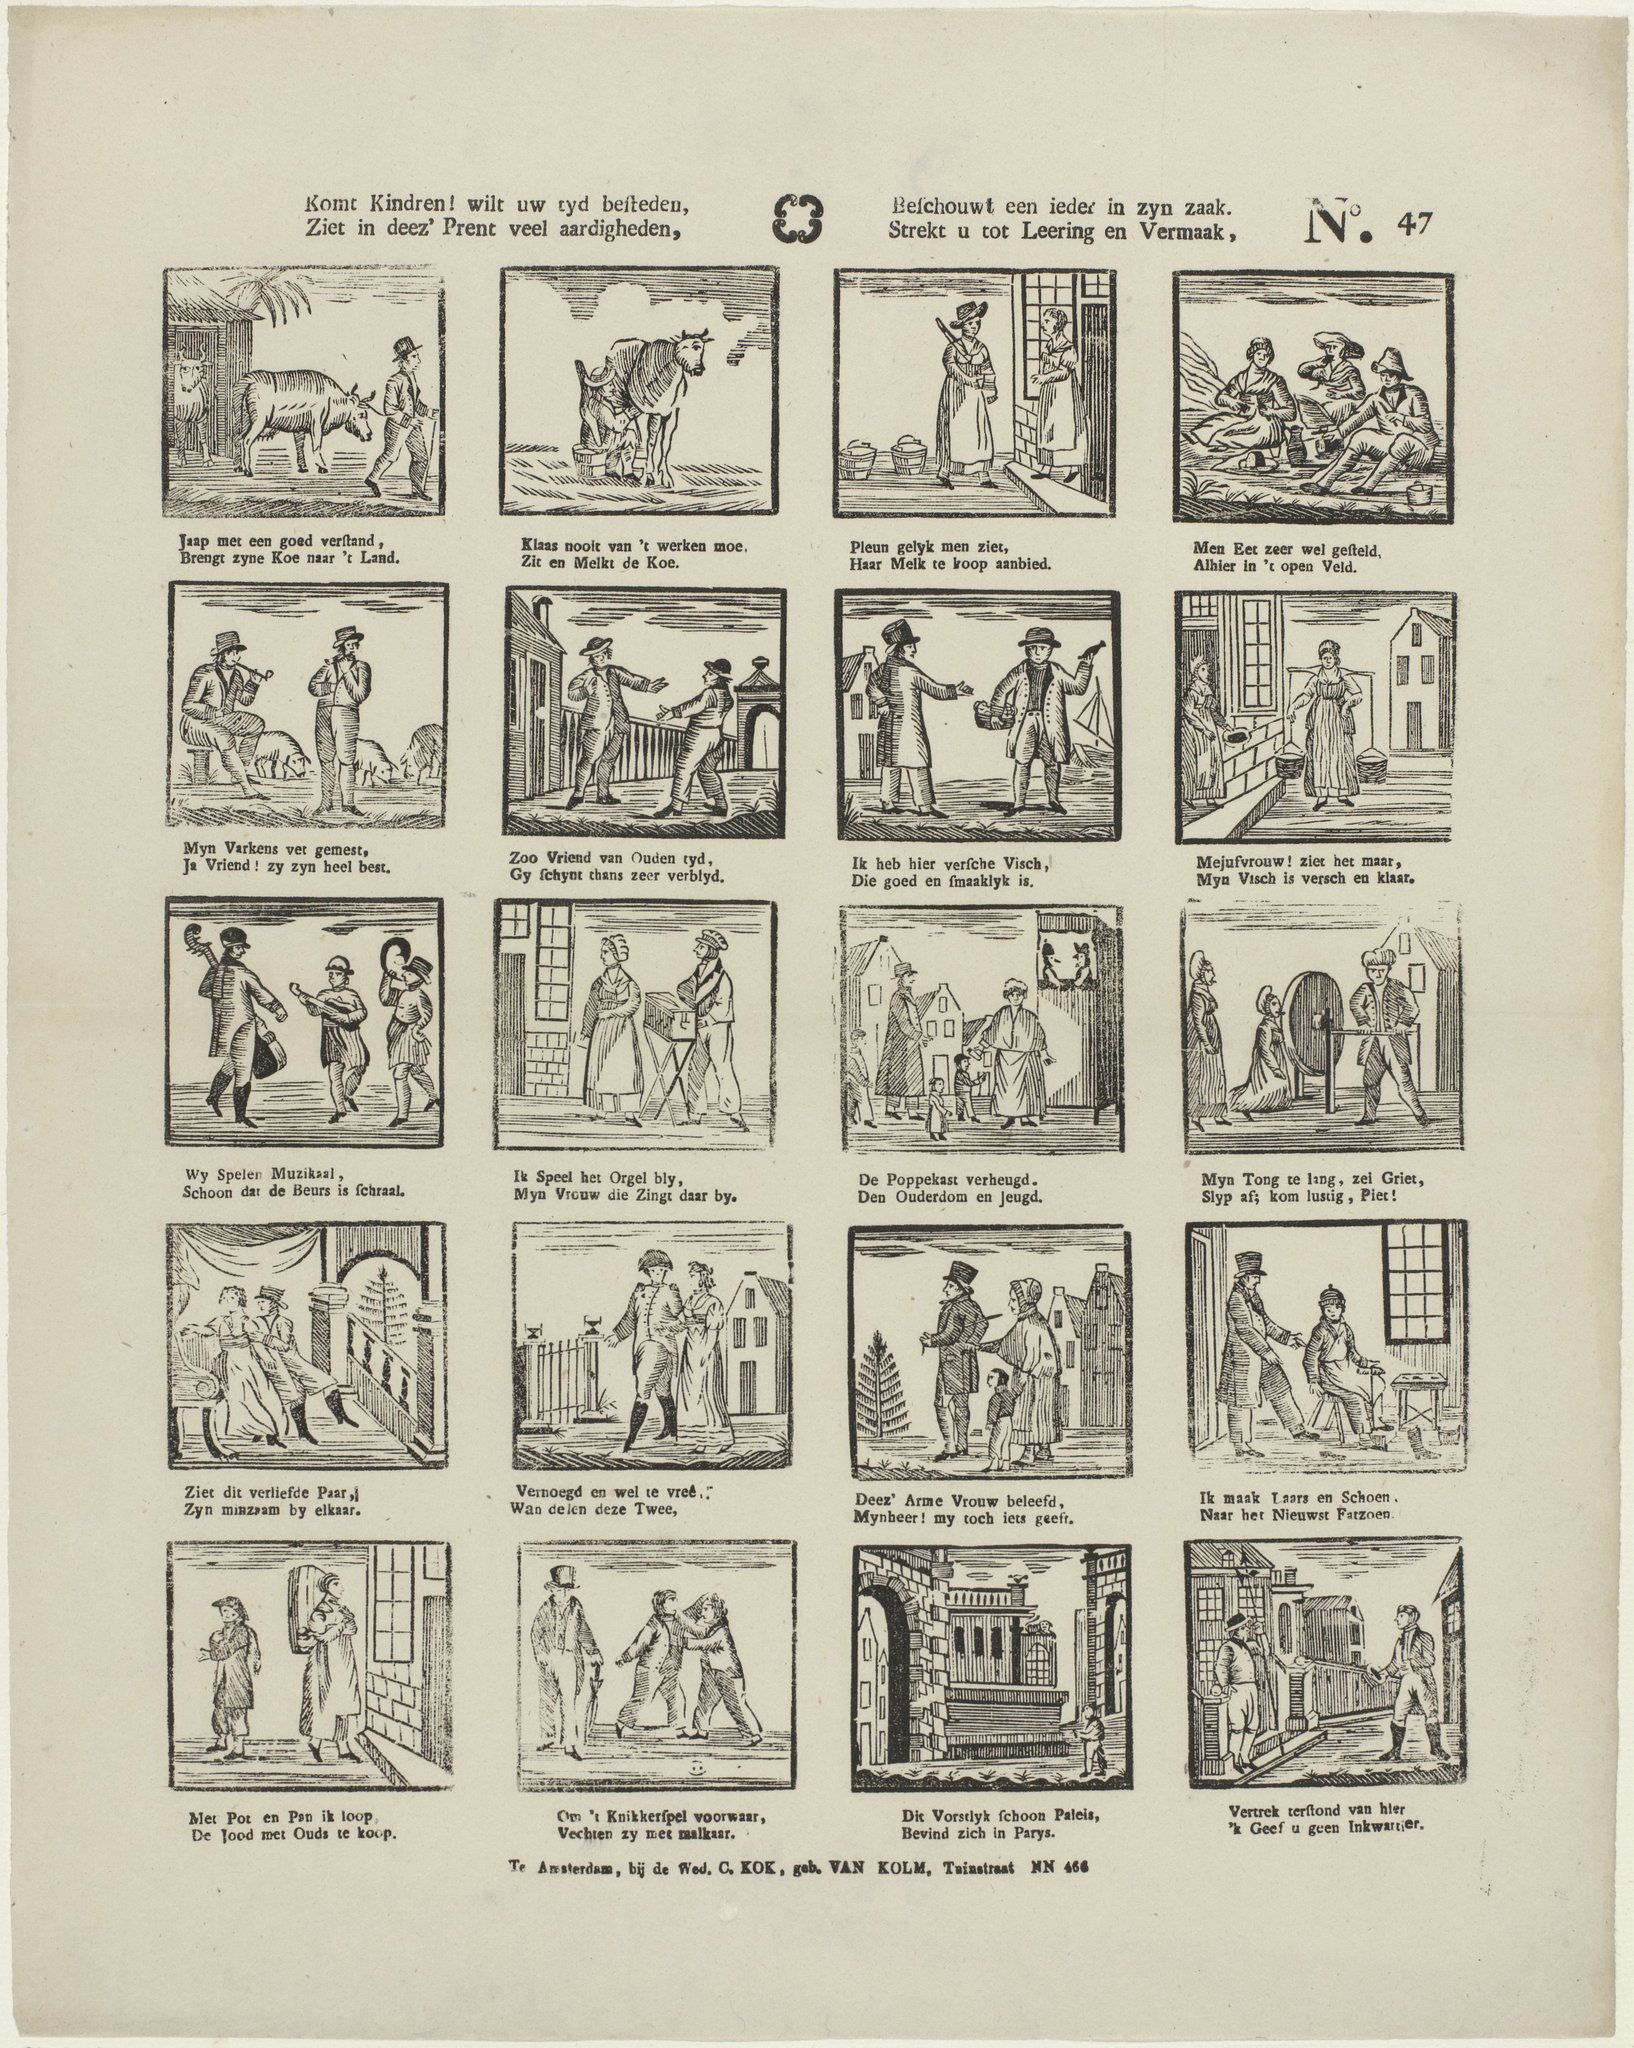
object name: popular print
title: Komt kinderen! wilt uw tyd besteden, / Ziet in deez' prent veel aardigheden, / Beschouwt een ieder in zyn zaak. / Strekt u tot leering en vermaak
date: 1842-1866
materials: paper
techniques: letterpress printing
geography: amsterdam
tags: musician at work, walking, hiking (recreation), milking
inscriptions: collector's mark: Lugt 2760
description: Blad met 20 voorstellingen van verschillende bezigheden, waaronder een koe melken, muziek maken en wandelen. Onder elke afbeelding een tweeregelig vers. Genummerd rechtsboven: No. 47.